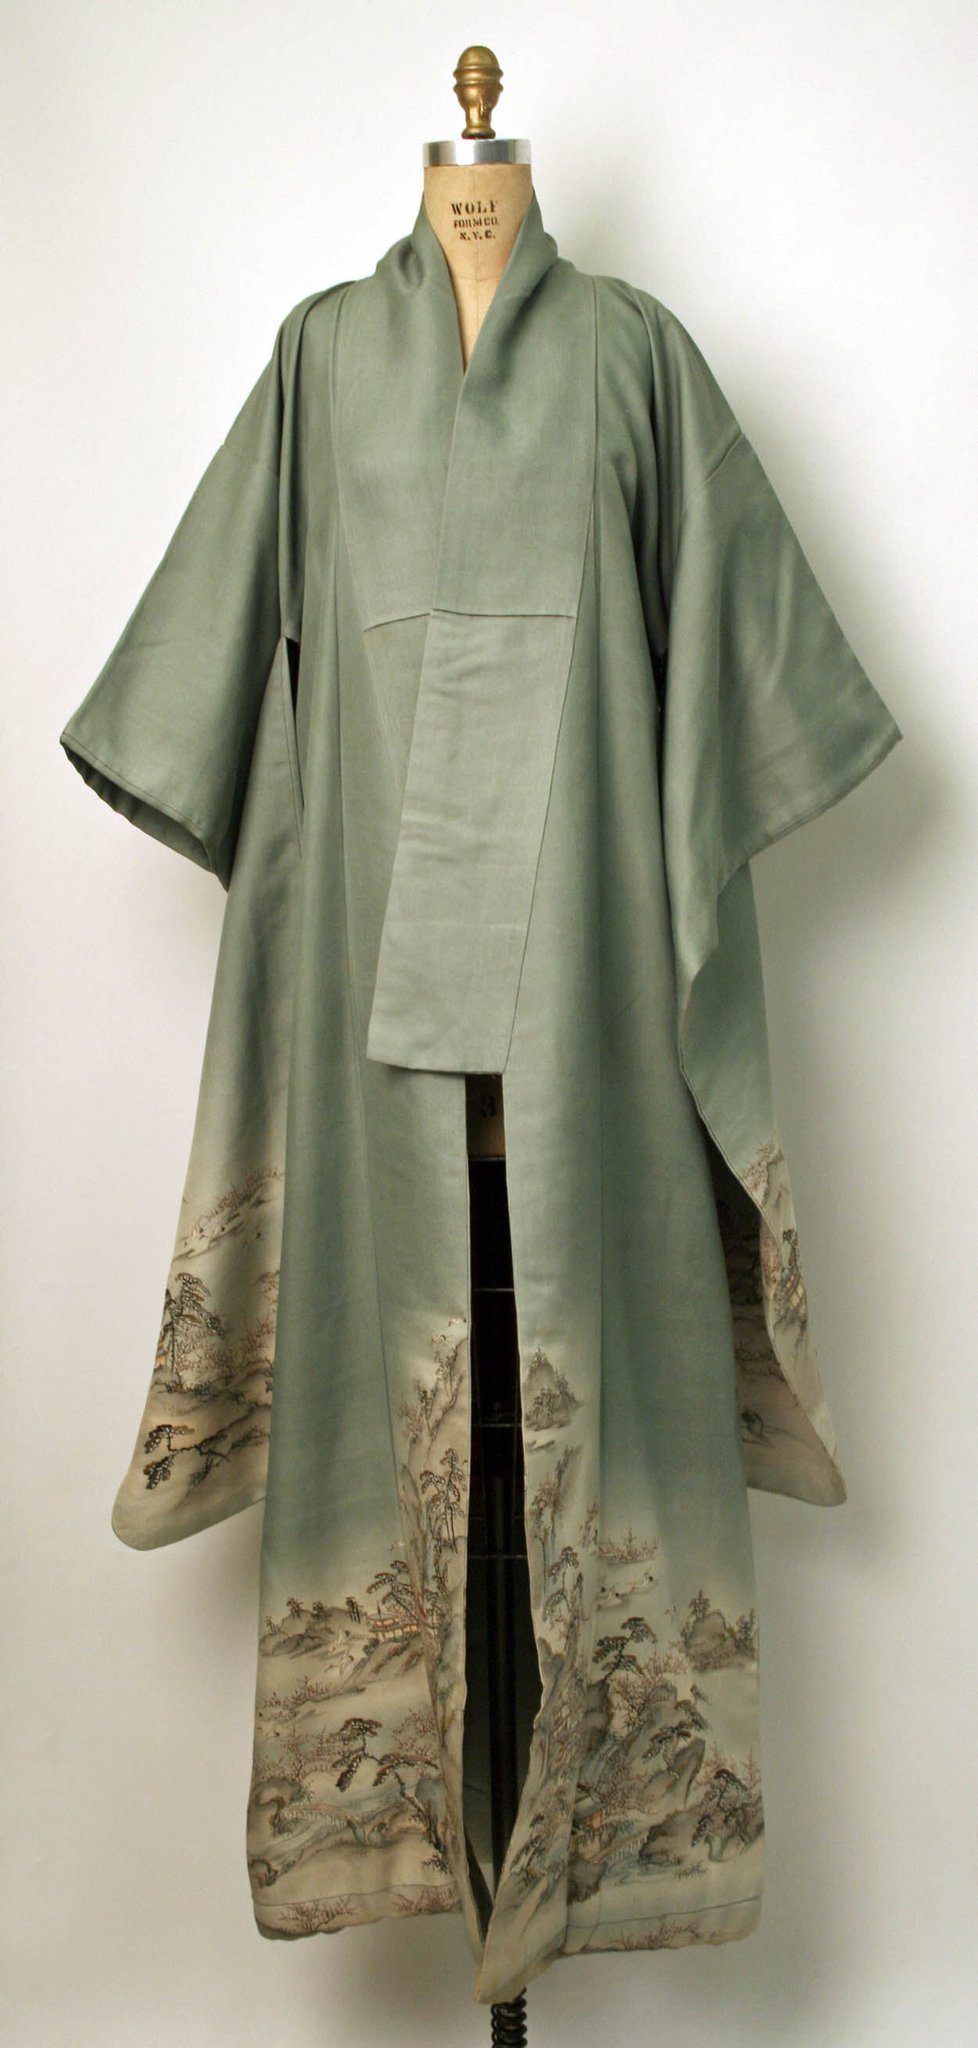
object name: kimono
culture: japanese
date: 1801-1900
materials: silk